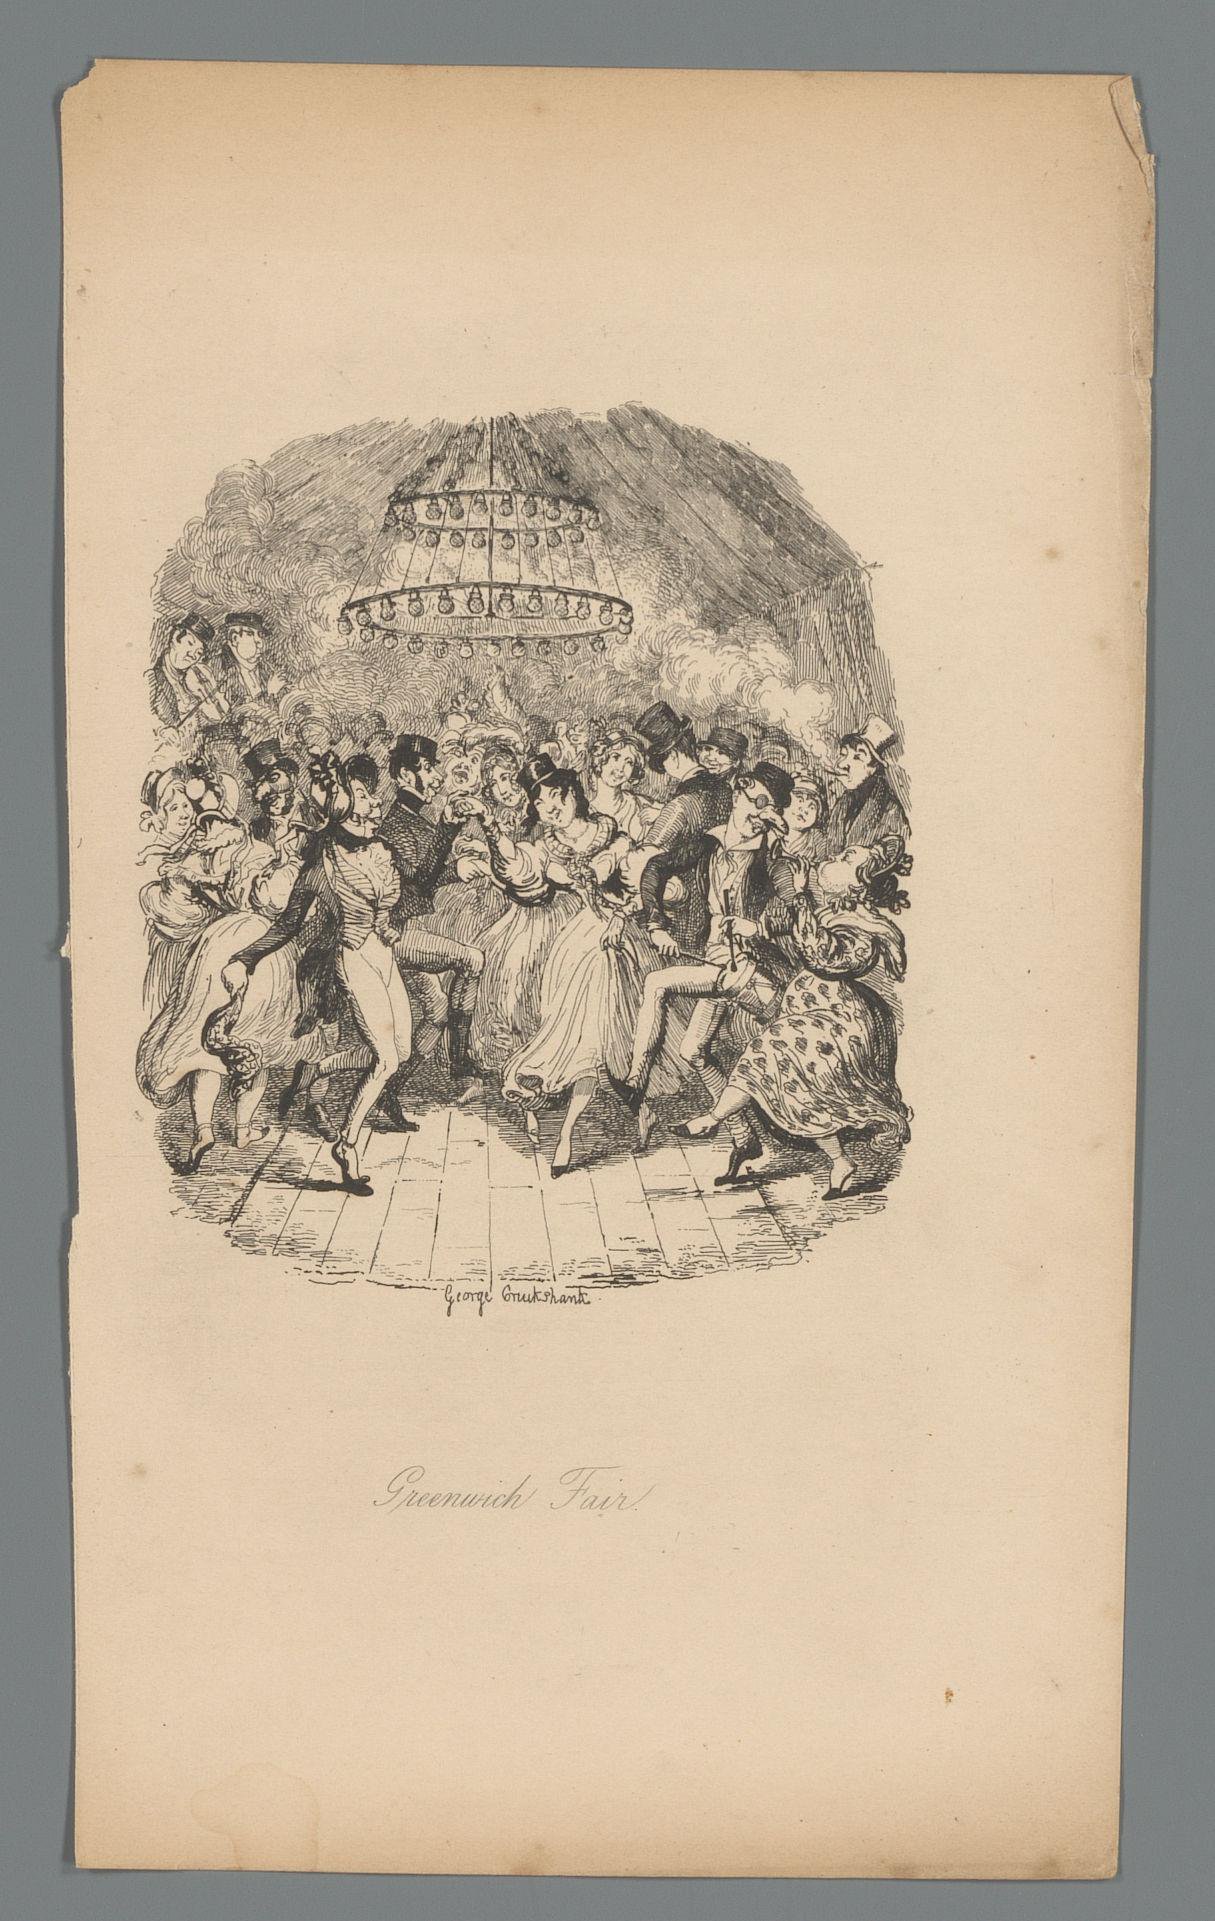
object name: cartoon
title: Greenwich Fair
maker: george cruikshank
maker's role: painter, print maker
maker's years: 1792-1878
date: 1836-1839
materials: paper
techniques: etching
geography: england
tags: masquerade, masked ball, pleasure fair and circus, political caricatures and satires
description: Greenwich Fair. Dansfeest in een tent. Sommige van de dansers dragen maskers. Illustratie voor een uitgave van Sketches by 'Boz' van Charles Dickens, 1836-1839.